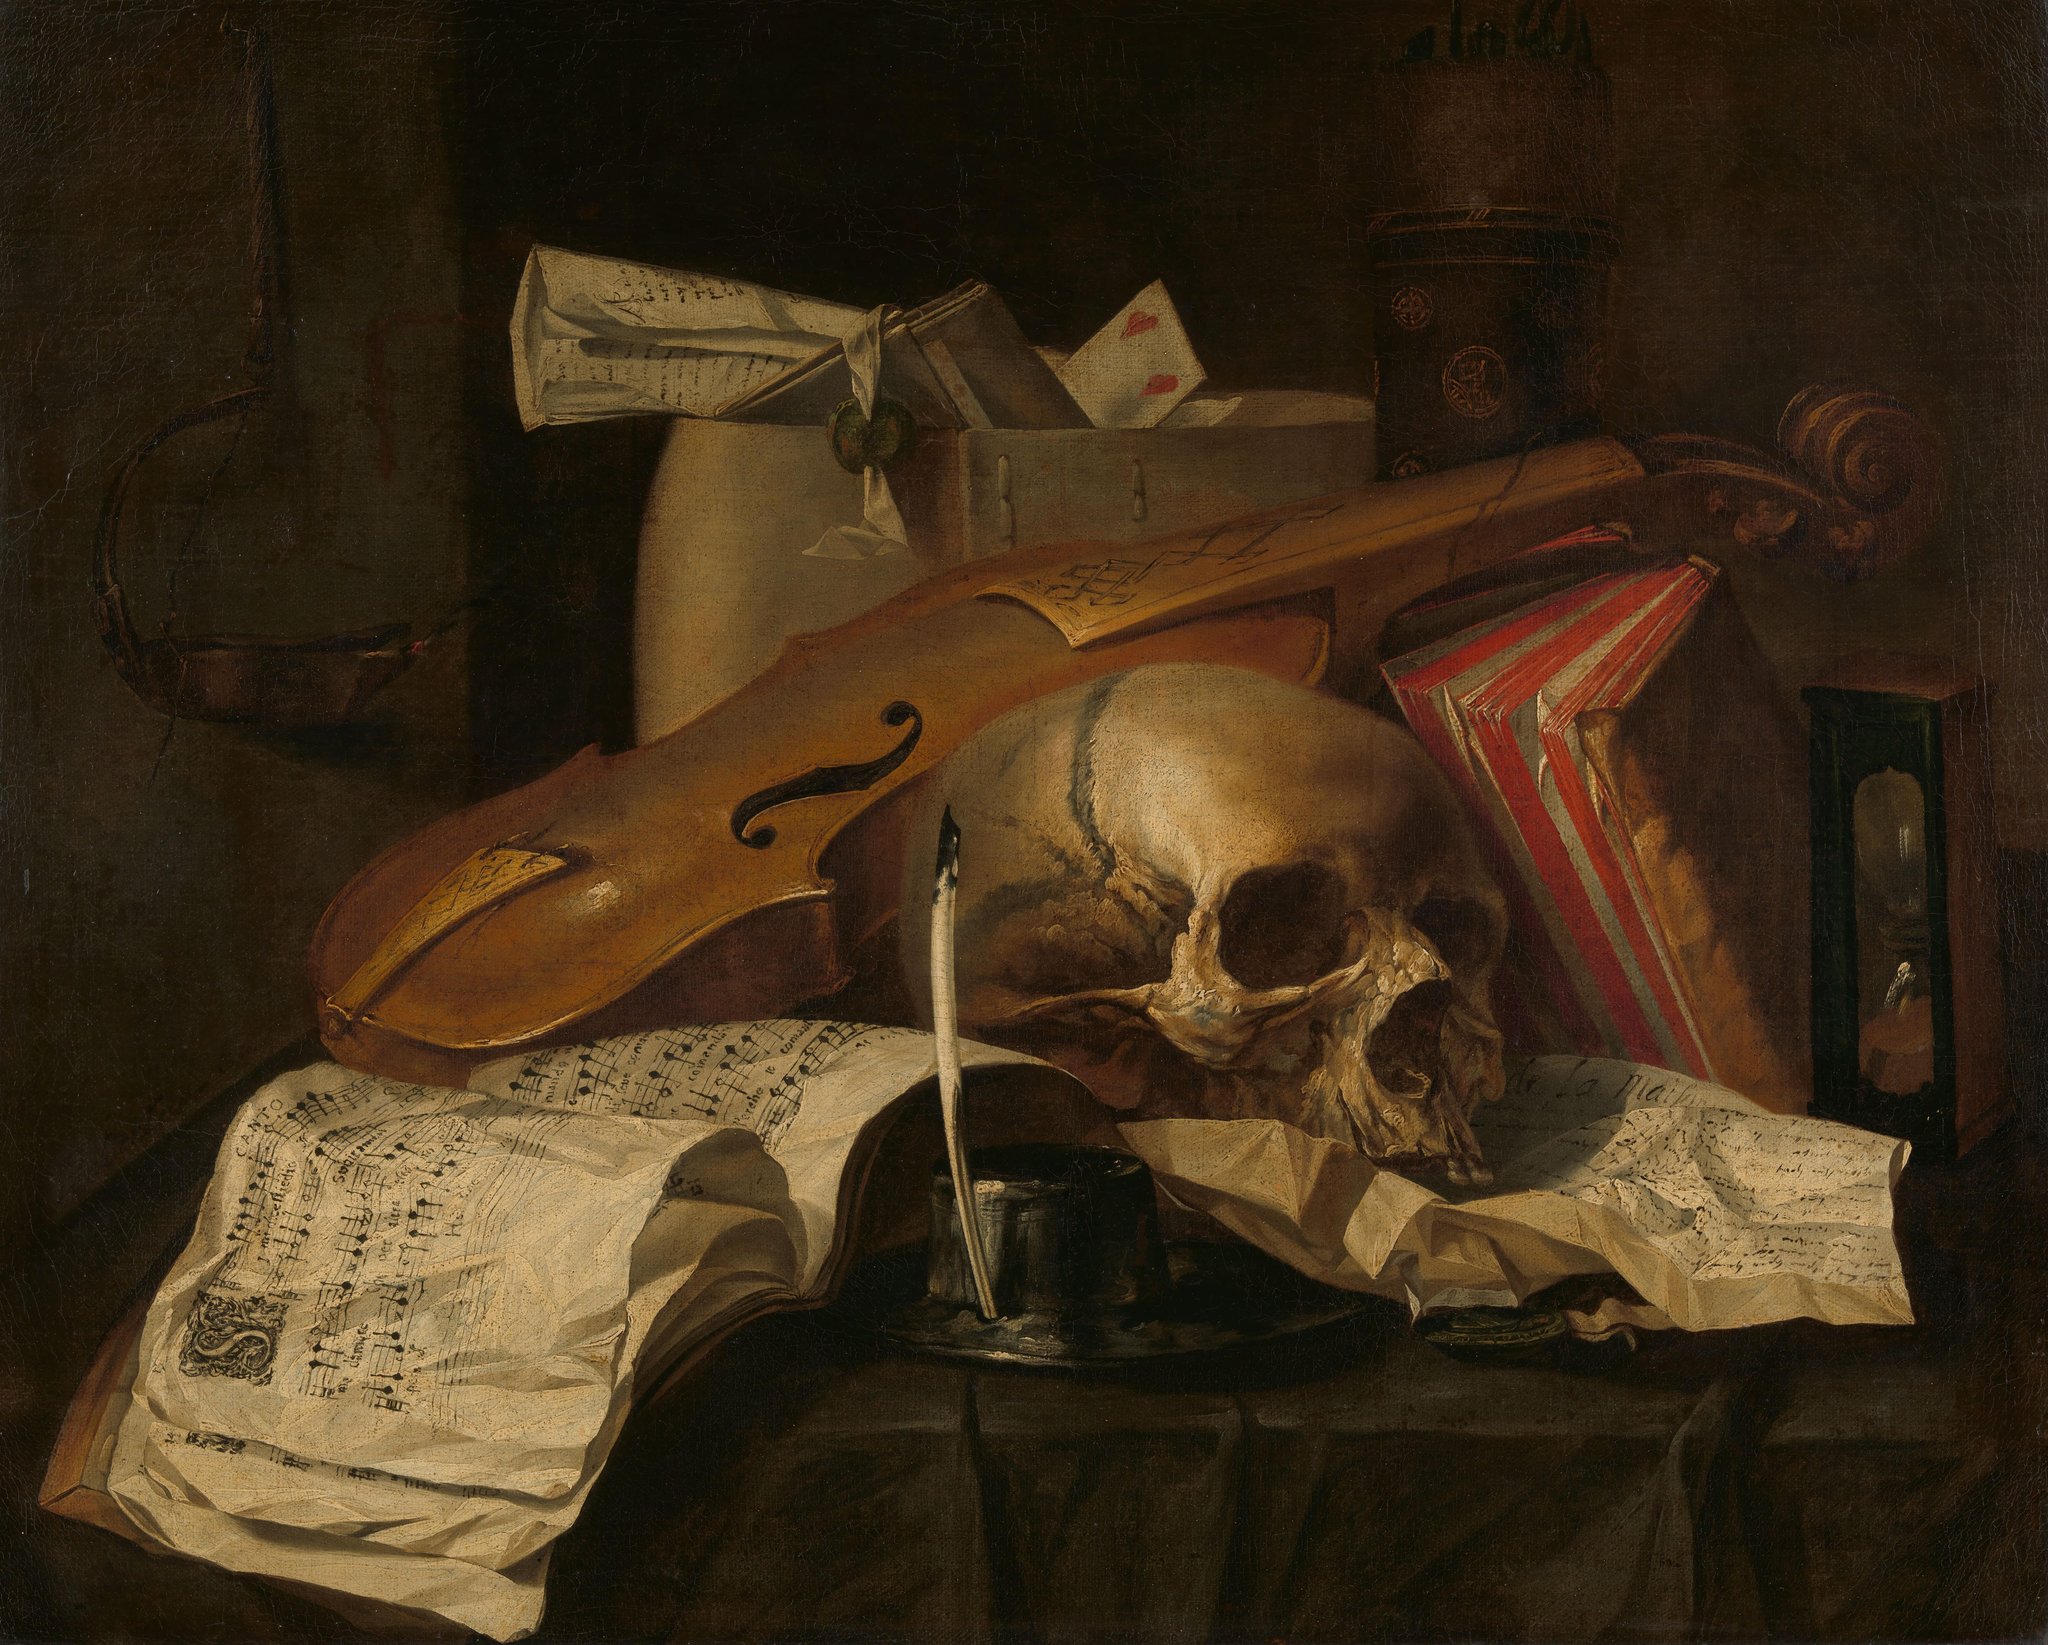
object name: painting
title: Vanitas still life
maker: n.l. peschier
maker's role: painter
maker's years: -1680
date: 1660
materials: canvas, oil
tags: (personifications of) 'vanitas', the vanity of human life; fragilità humana, fugacità delle grandezze & della gloria mondana, meditatione della morte, opera vana, piacere vano, vana gloria, vanità (ripa), still life of related objects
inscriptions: signature and date: ‘Peschier: fecit. 1660.’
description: Vanitas stilleven. Op een tafel liggen een viool, een schedel, een liedboek, een inktstel, een verfrommeld brief met zegel, boeken, een zandloper en een tas met documenten. Aan de muur een smeulende olielamp.